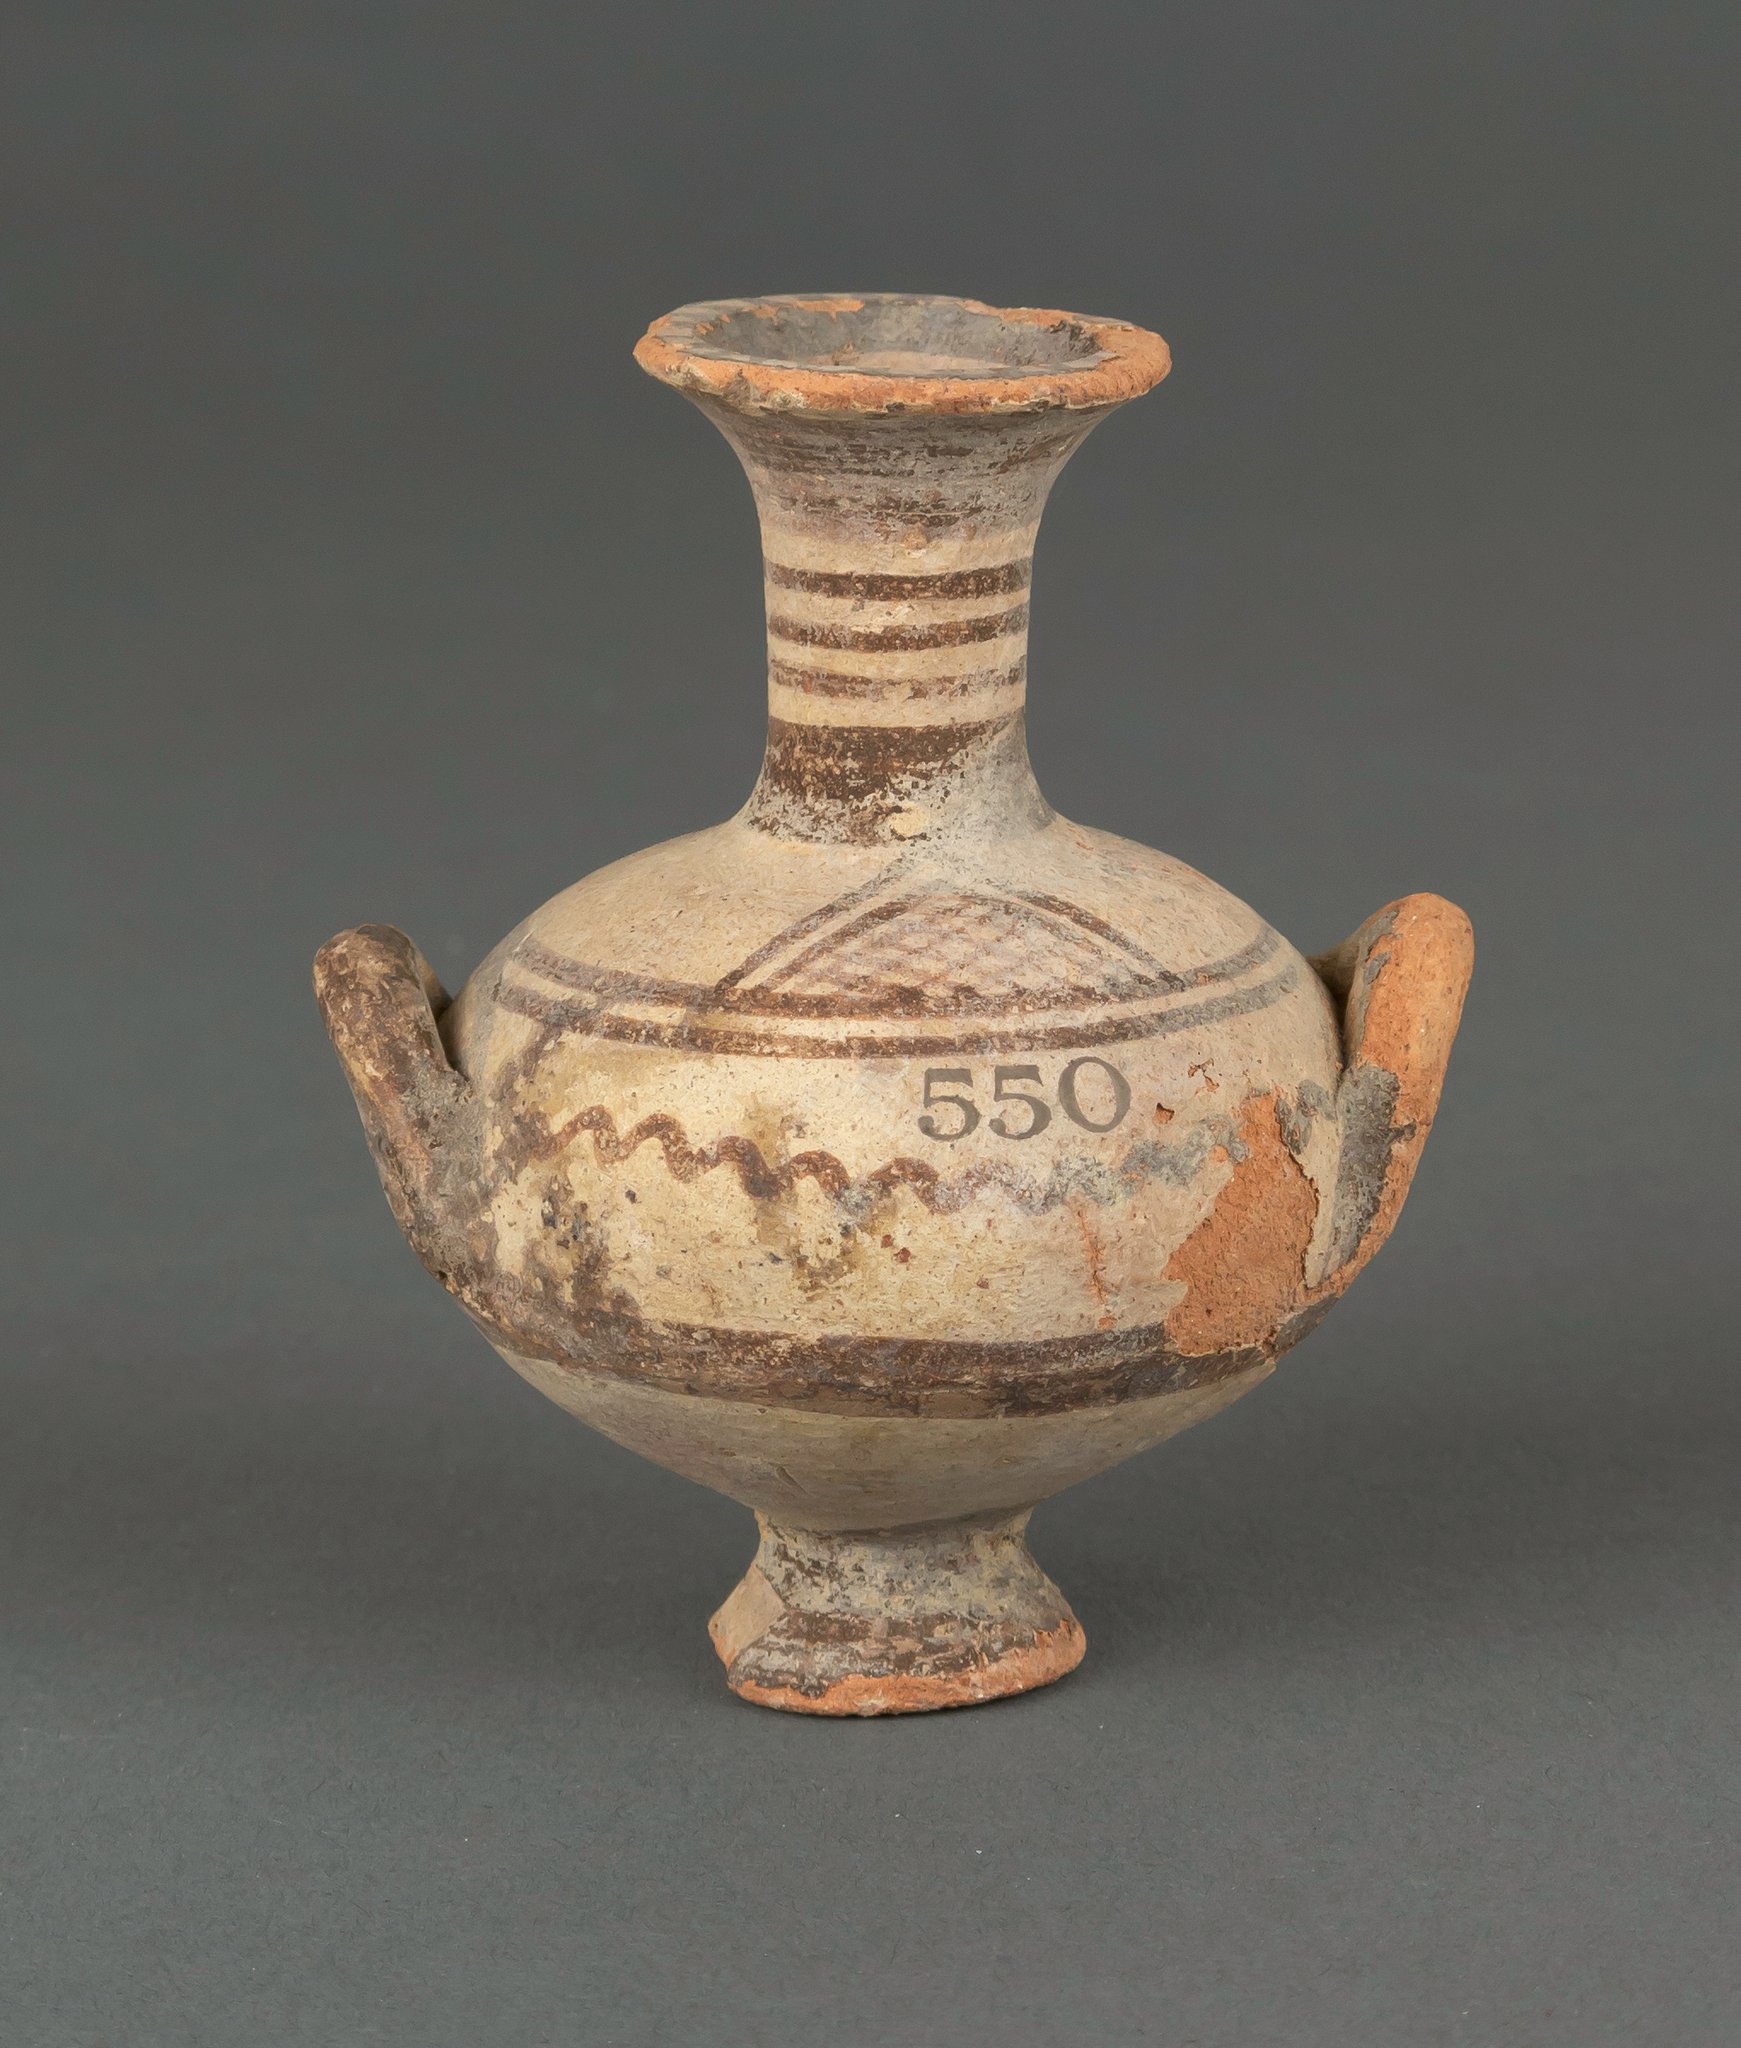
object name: juglet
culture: cypriot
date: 1050-950 BCE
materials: terracotta